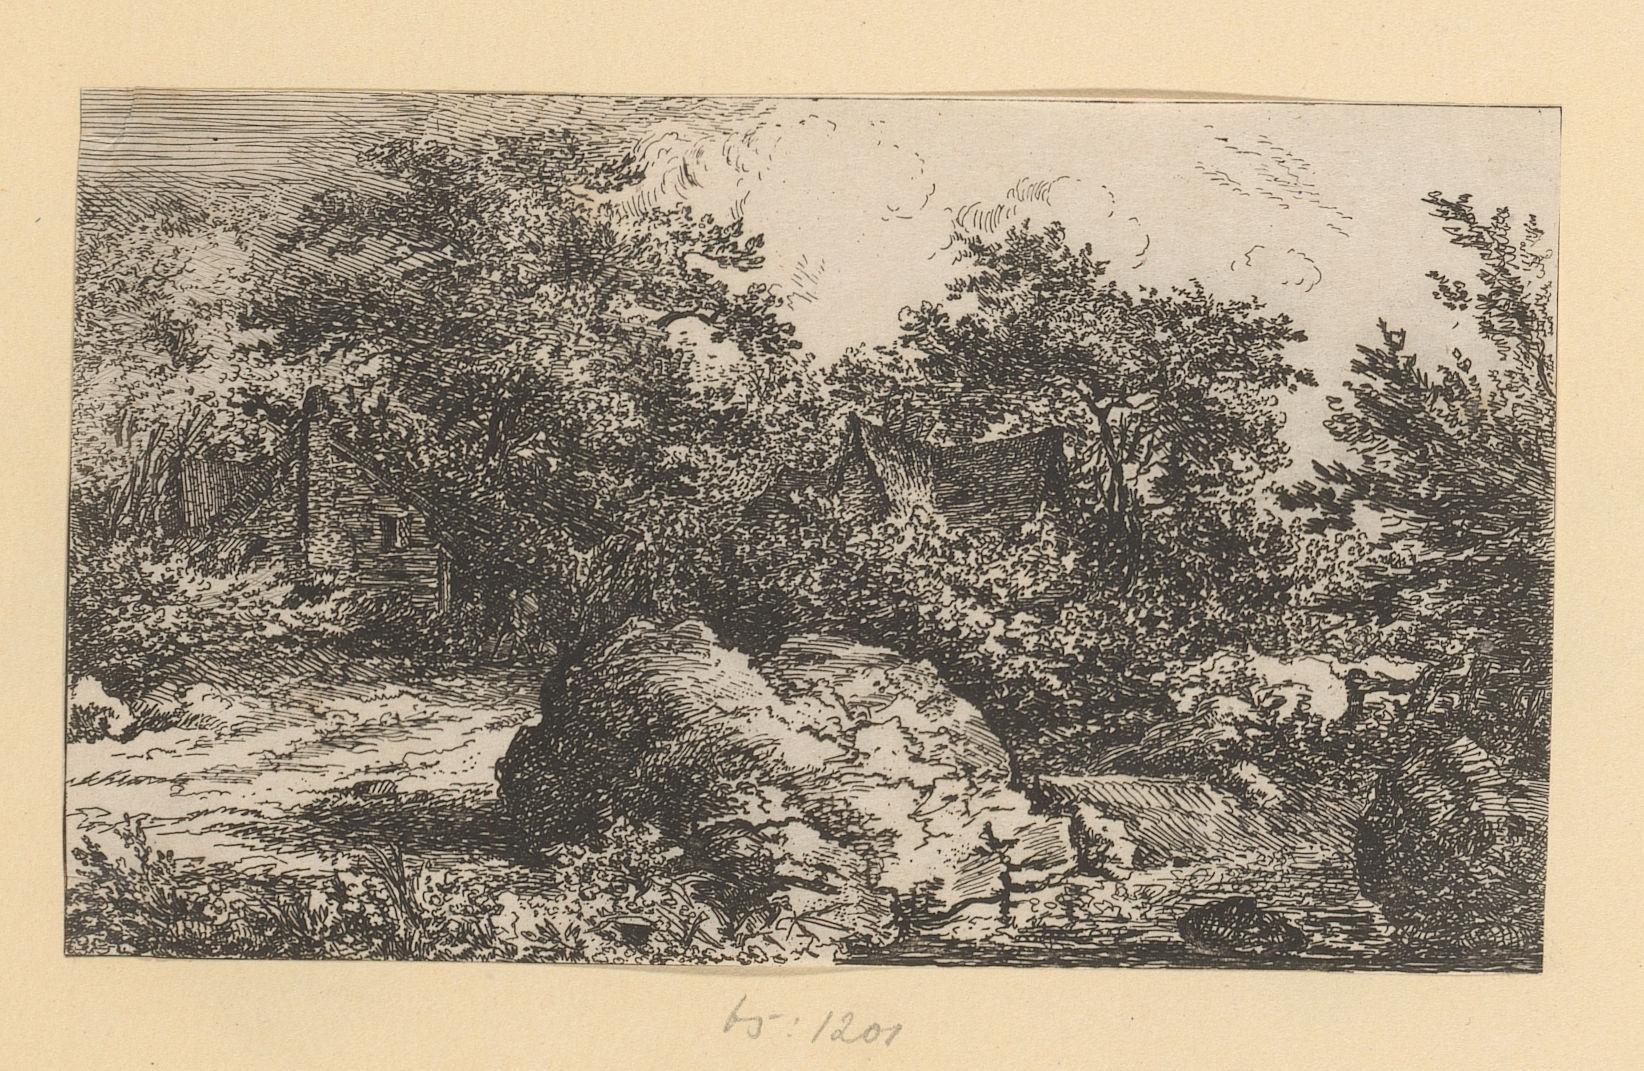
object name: album leaf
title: Reeks landschappen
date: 1793-1795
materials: paper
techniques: etching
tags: landscapes (+ landscape with figures, staffage), farm (building)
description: Deze prent hoort bij een serie van 20 prenten. Prent maakt mogelijk deel uit van een serie van 200 prenten. Deze serie is onder de titel 'A Collection of two hundred original etchings' voor het eerst uitgegeven door J.M. Greery in 1816.